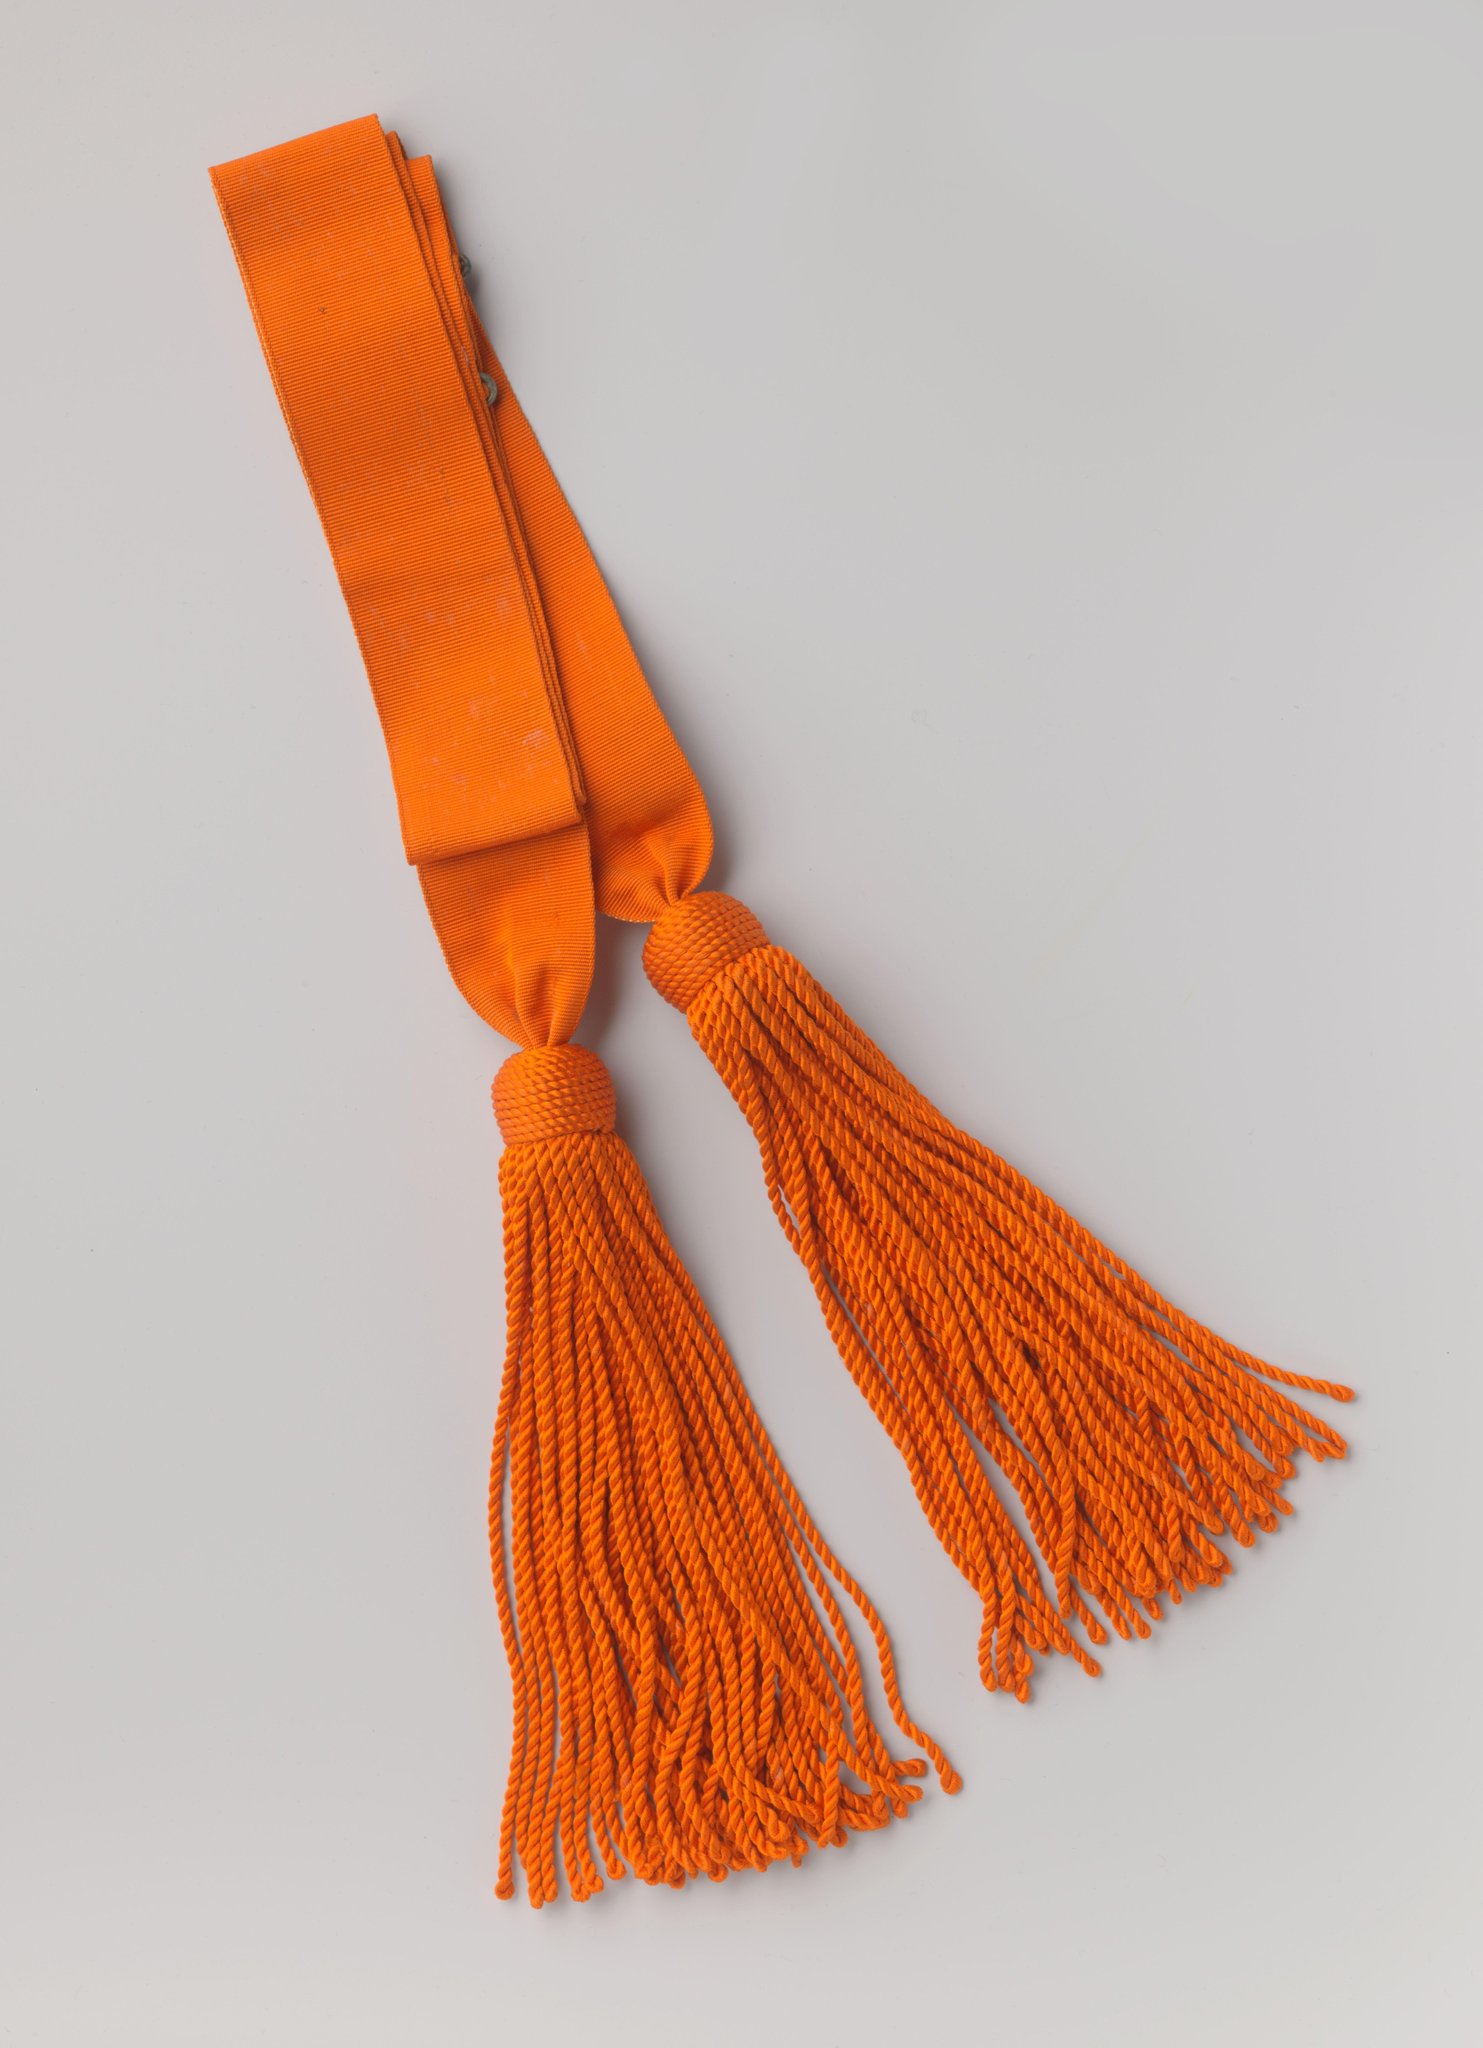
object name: uniform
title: Sjerp van oranje ripslint, met twee verzilverde gespen em eindkwasten van dik en lang koord, met een hoofdje in de vorm van een halve bol; geborgen in een doosje (b)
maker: Anonymous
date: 1885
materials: ribbon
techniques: silvering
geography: amsterdam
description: Notitie in doosje: "W. Six 1859-1928/1885". Volgens Bas Kist is het een laat 19de eeuwse zijde-soort, in de 20ste eeuw nog in gebruik.